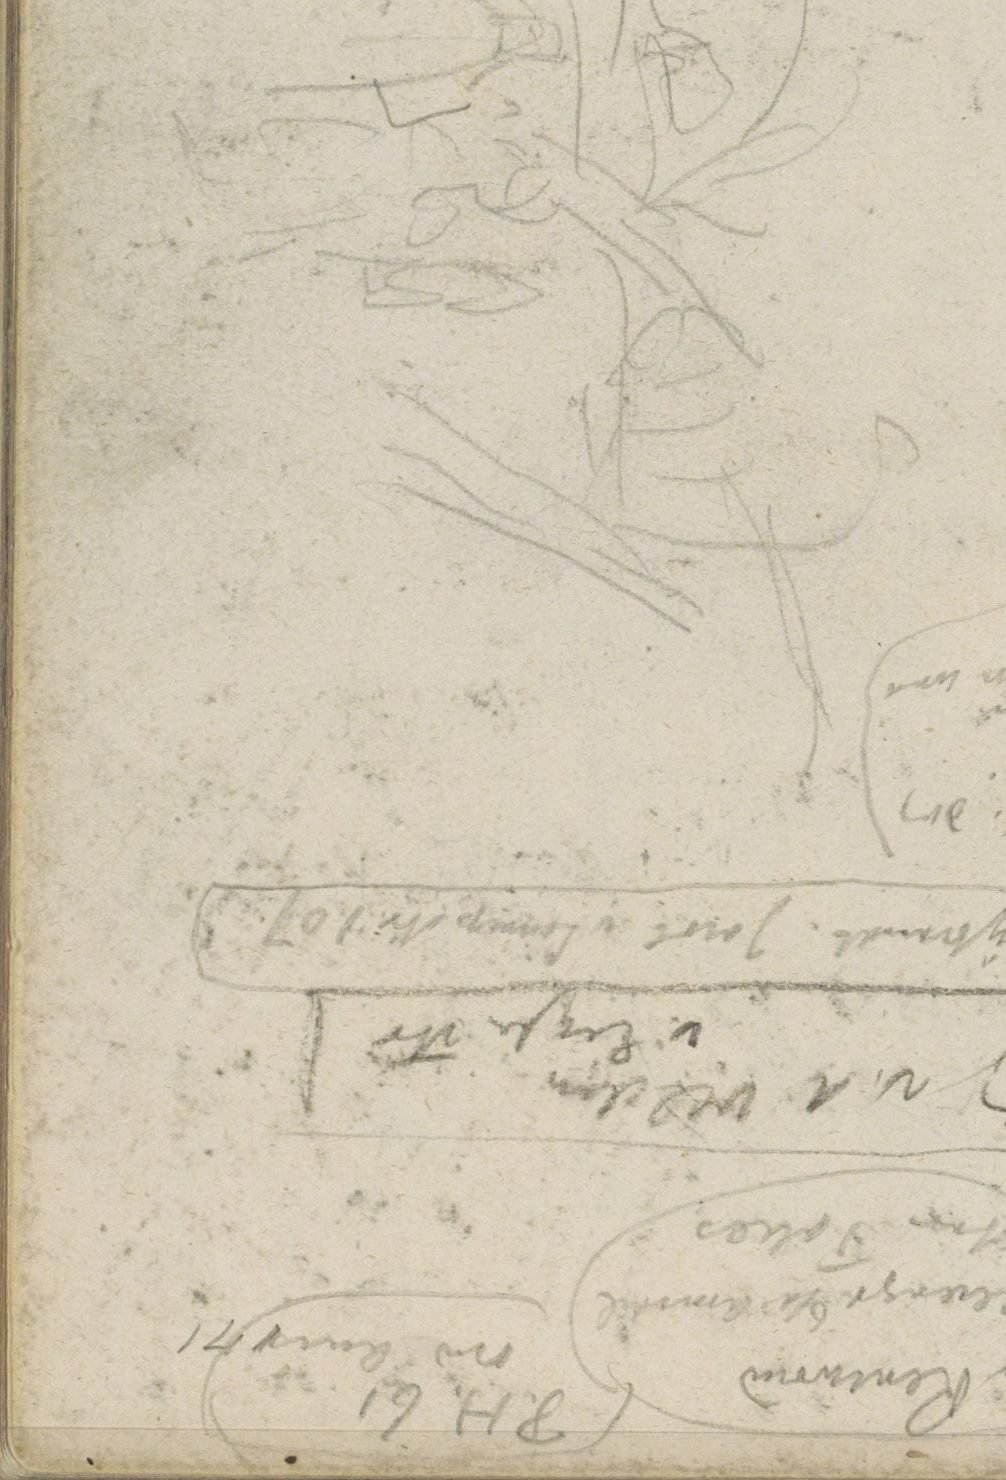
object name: sketchbook leaf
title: Figuren, mogelijk bij een boom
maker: george hendrik breitner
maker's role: draughtsman, painter, print maker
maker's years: 1857-1923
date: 1909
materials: paper, pencil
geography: amsterdam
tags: trees, adult man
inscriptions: address: ‘P.H. 61/ nw huis[?] 171’, address: ‘Van Renswoud/ Heerengr 6/a[?] Amstel/ [...]’, address: ‘Leijbrandt. Jacob v. Lennepstr. 107.’, address: ‘[...] v.d. Velden/ v. Eykstr’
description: Figuren, mogelijk bij een boom. Pagina 91 uit een schetsboek met 45 bladen vervaardigd in Amsterdam en Pittsburgh.